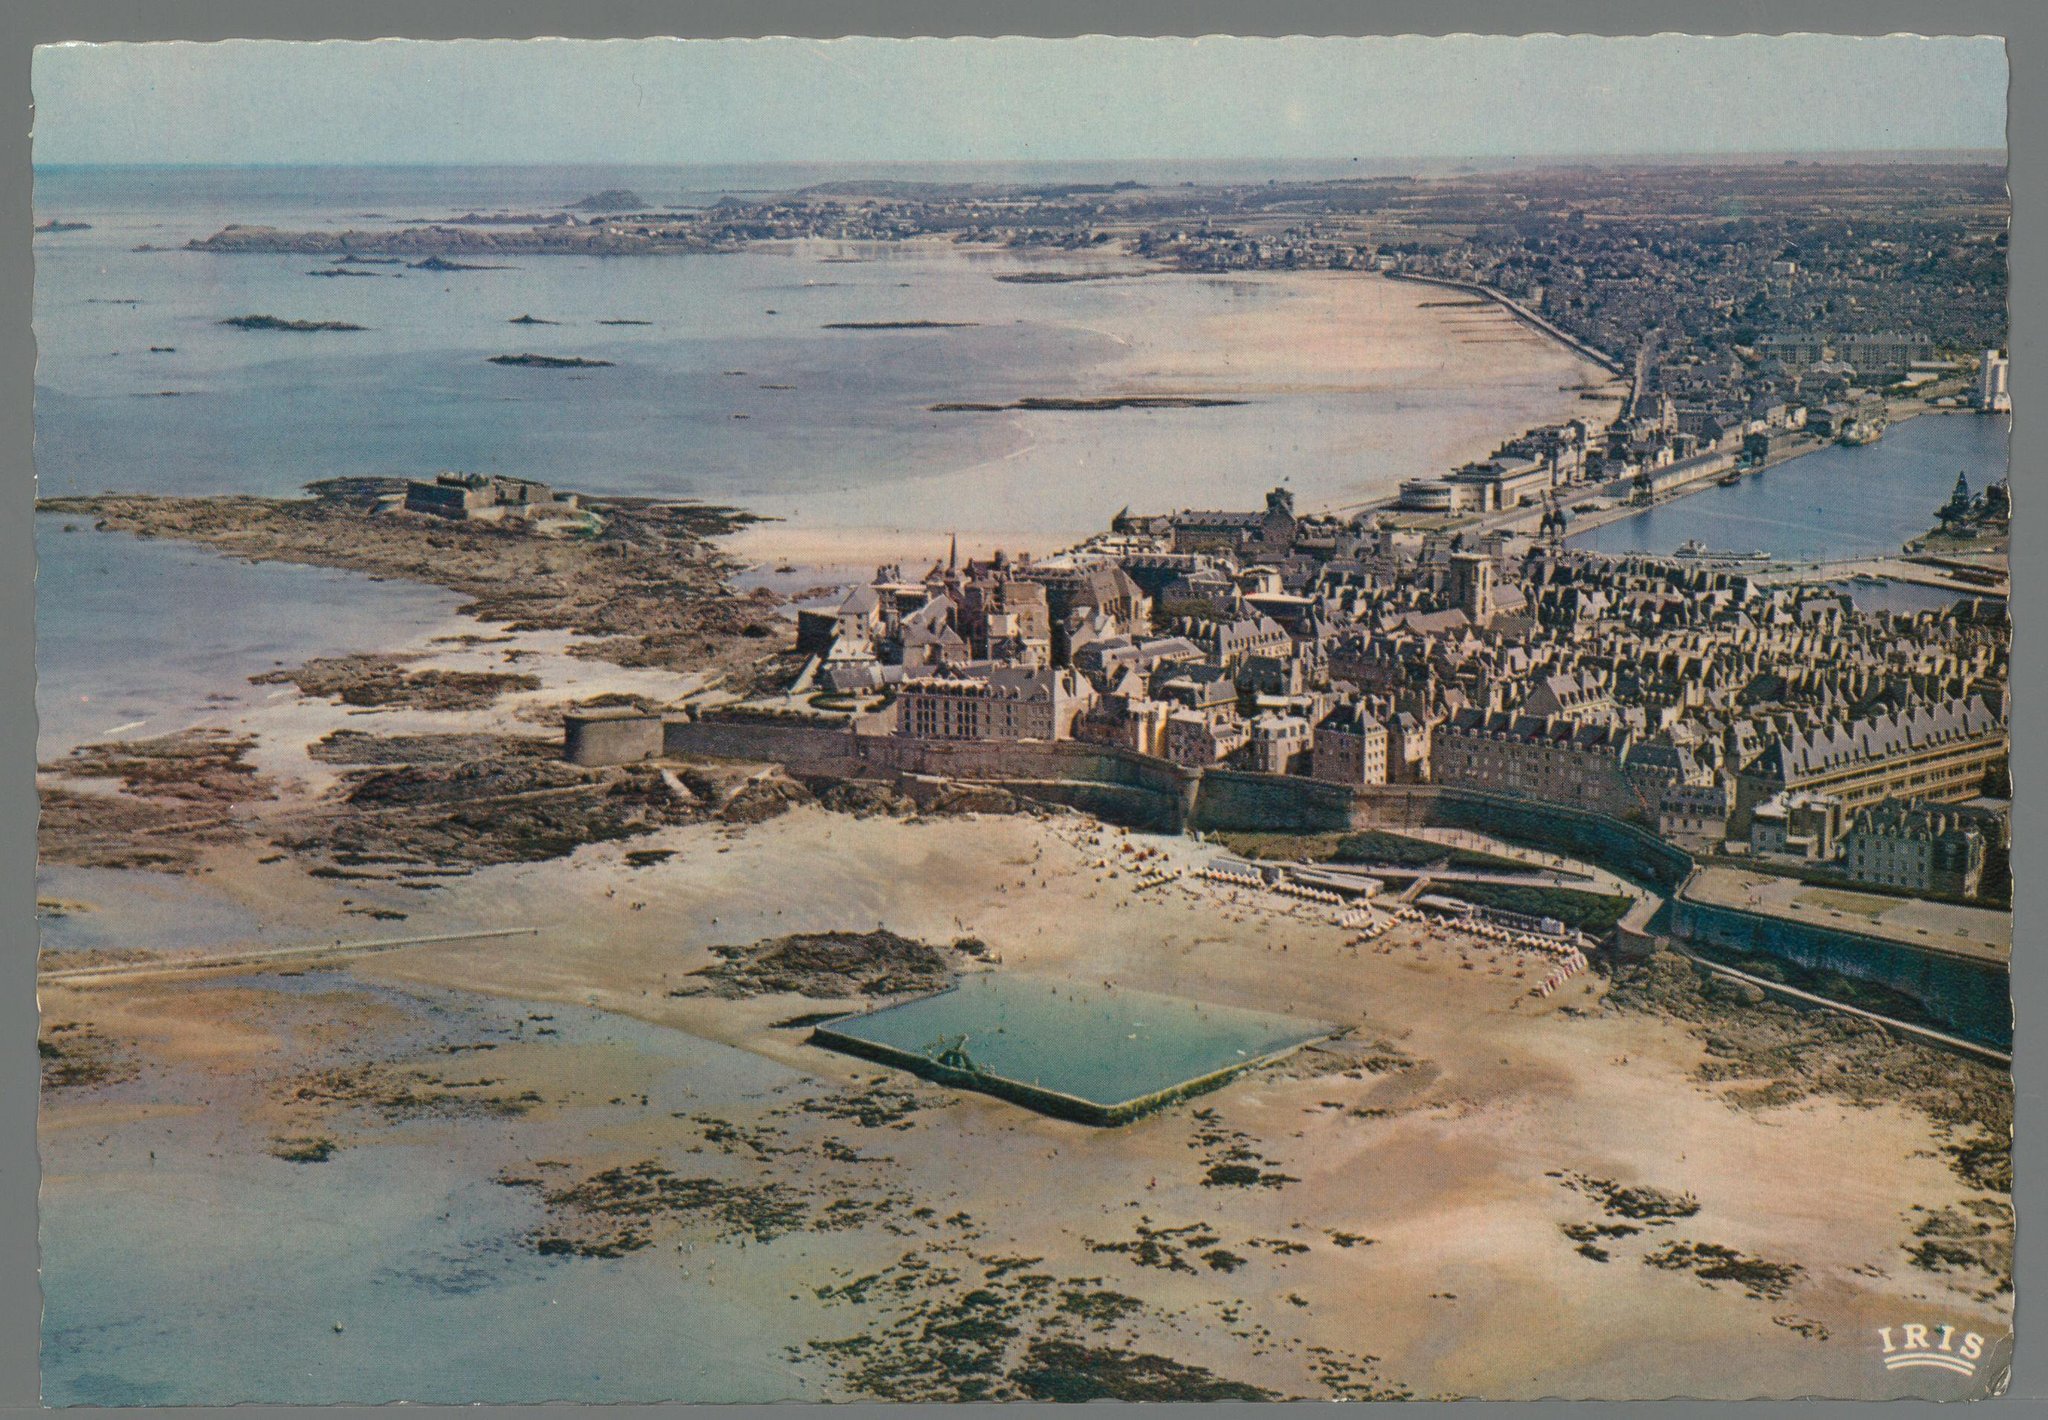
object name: photomechanical print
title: Saint-Malo. Cité corsaire. Vue aérienne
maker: spirale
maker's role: fotograaf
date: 1950-1969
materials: cardboard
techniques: four-color rotogravure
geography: paris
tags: coast, prospect of city, town panorama, silhouette of city